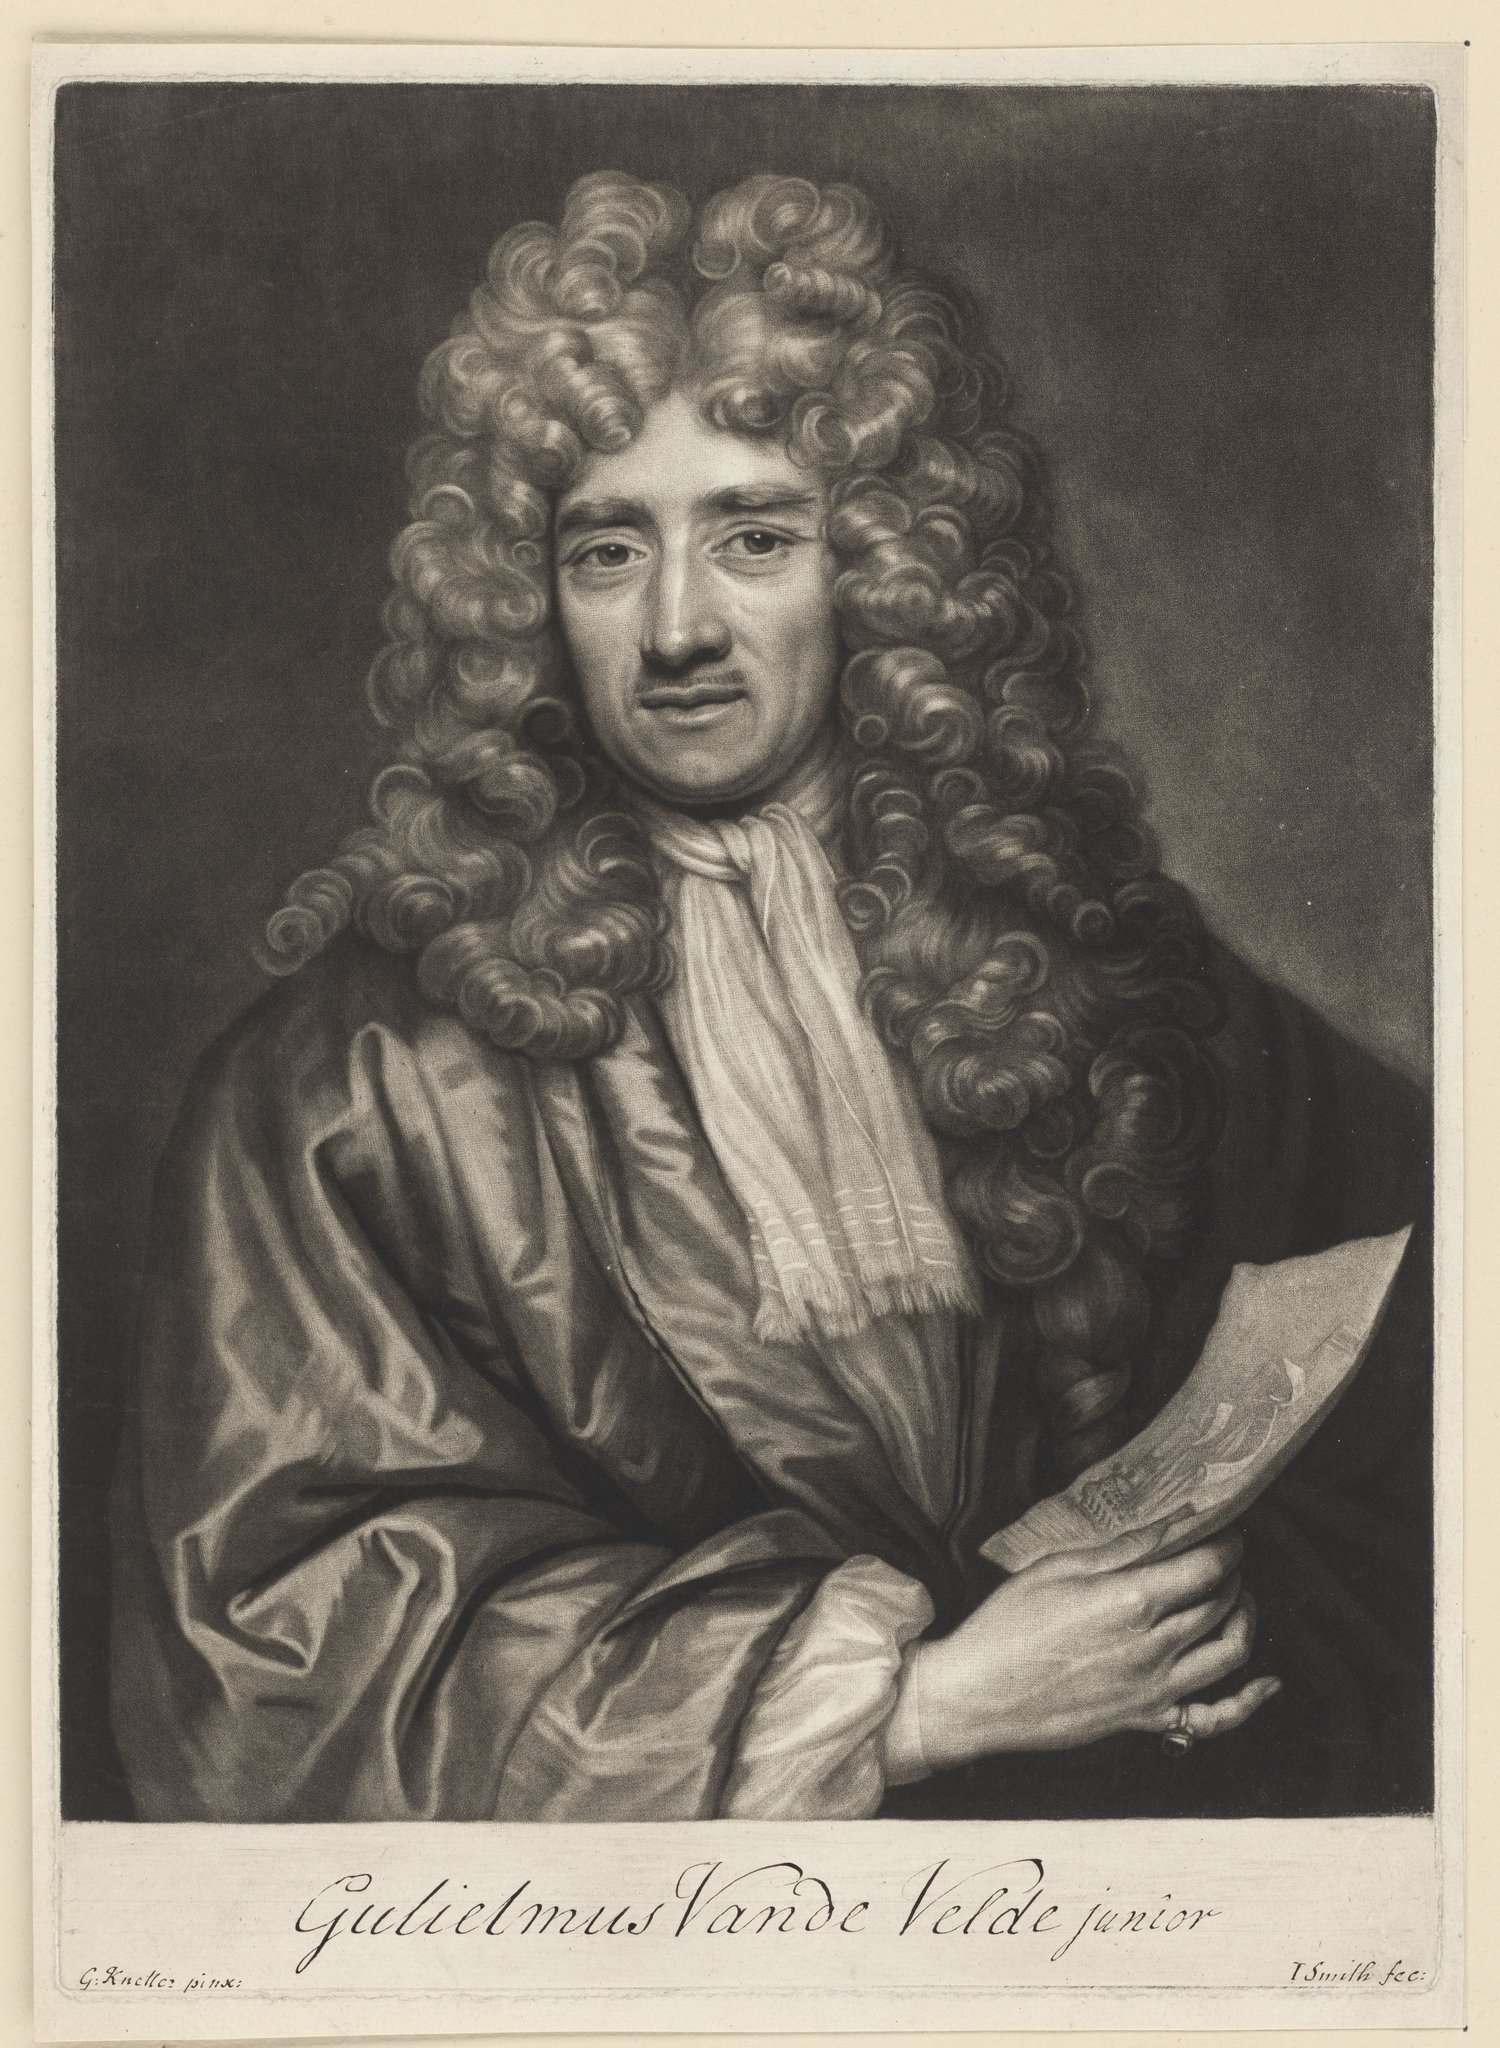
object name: print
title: Portret van Willem van de Velde op 74-jarige leeftijd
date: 1707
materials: paper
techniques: mezzotint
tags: leiden, london, painter, draughtsman, willem van de velde (ii), historical persons, portrait, self-portrait of painter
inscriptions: collector's mark: Lugt 240